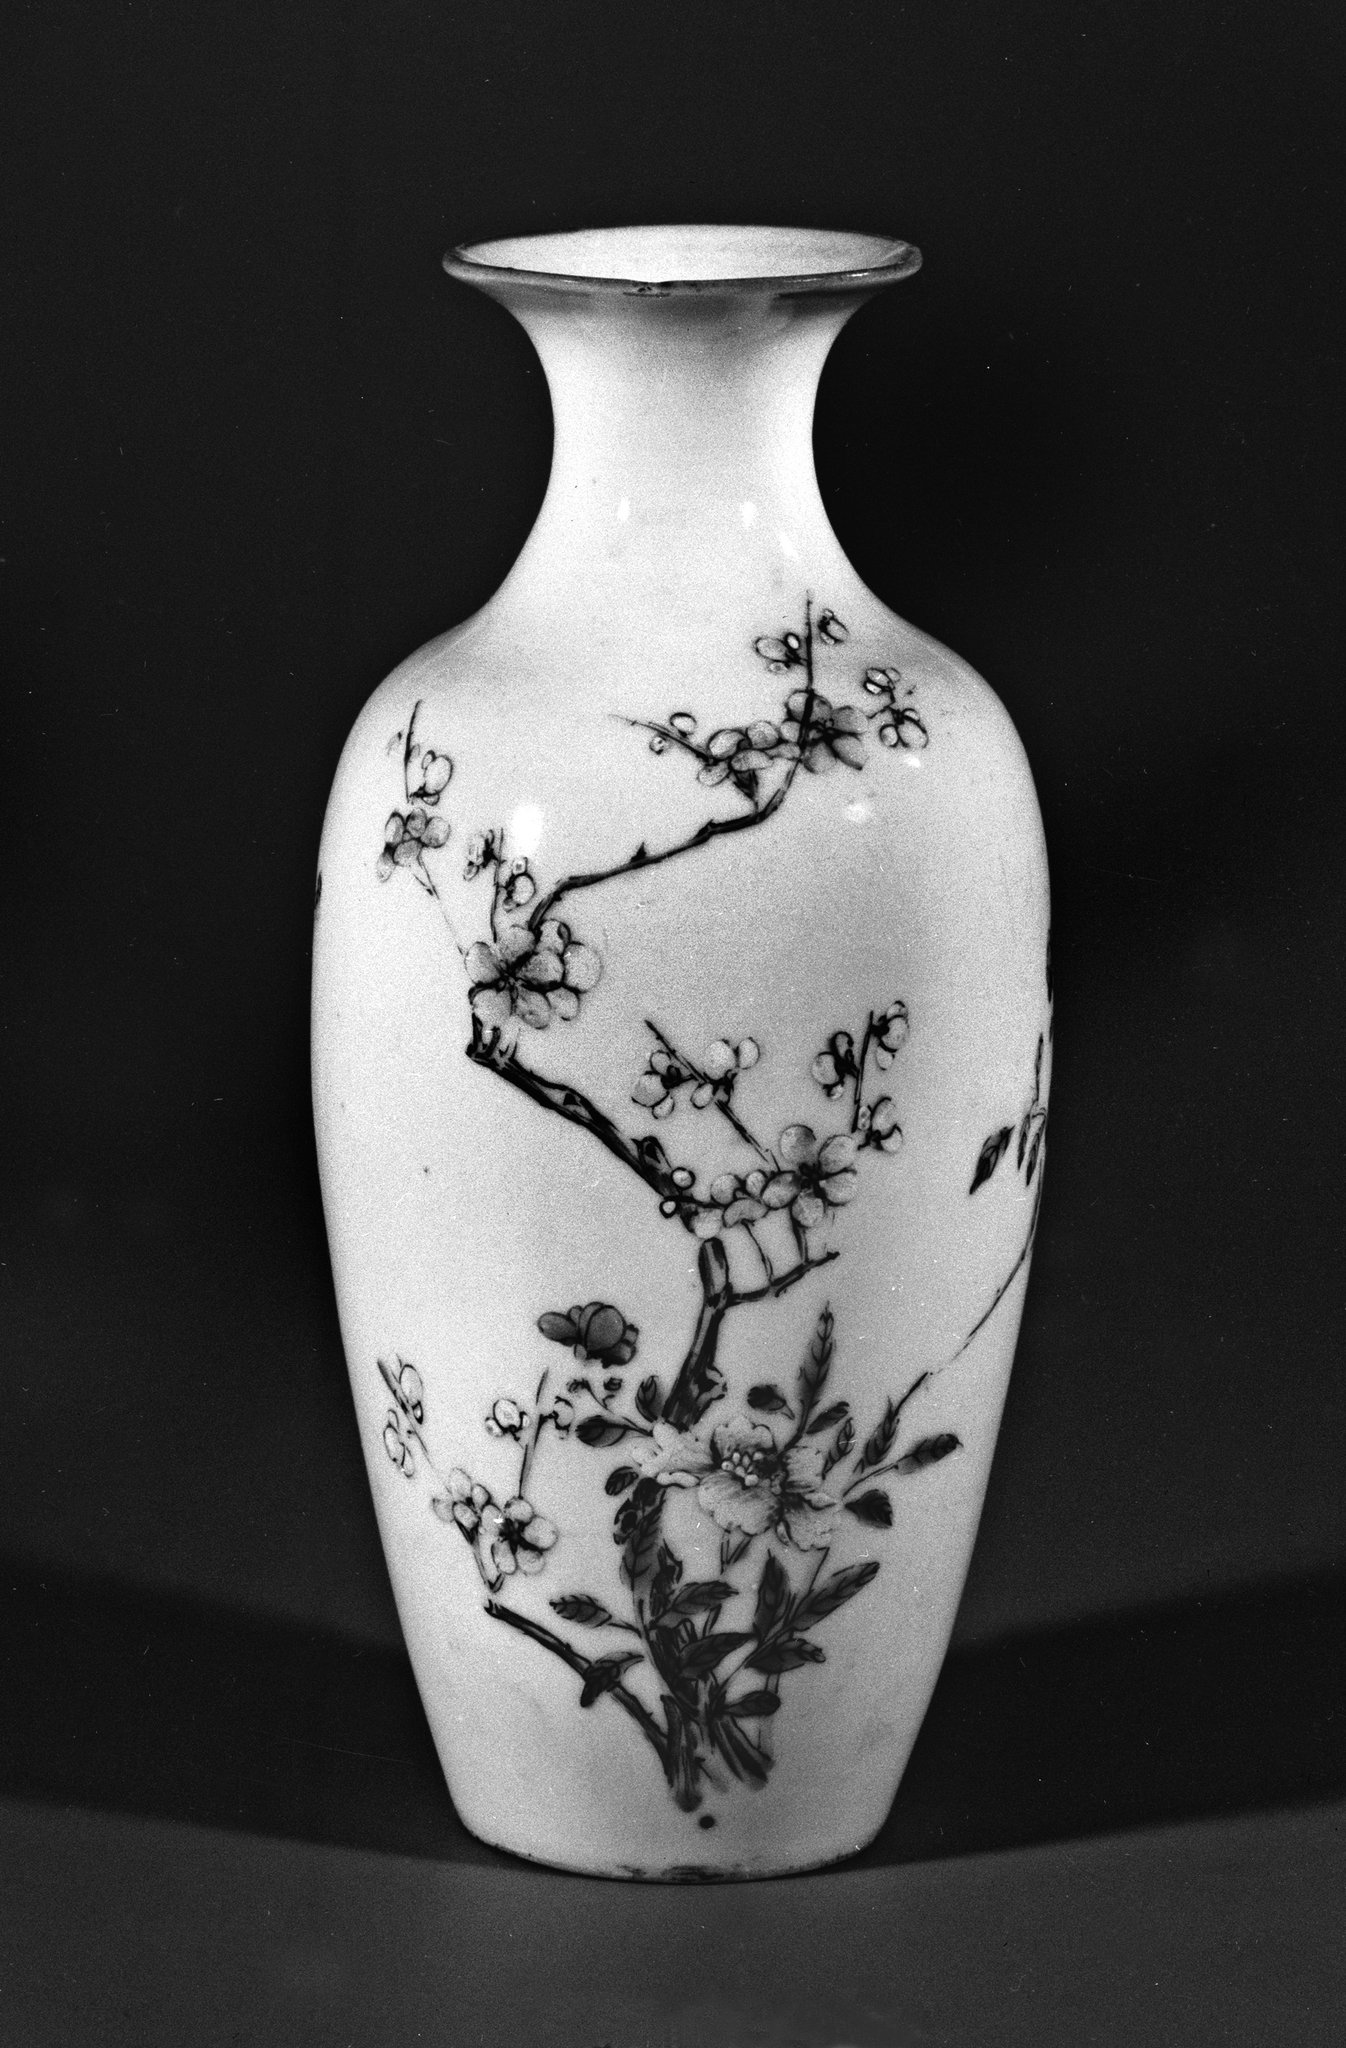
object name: vase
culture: chinese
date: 1736-1795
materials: enamel, porcelain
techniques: glazing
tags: flowers,leaves